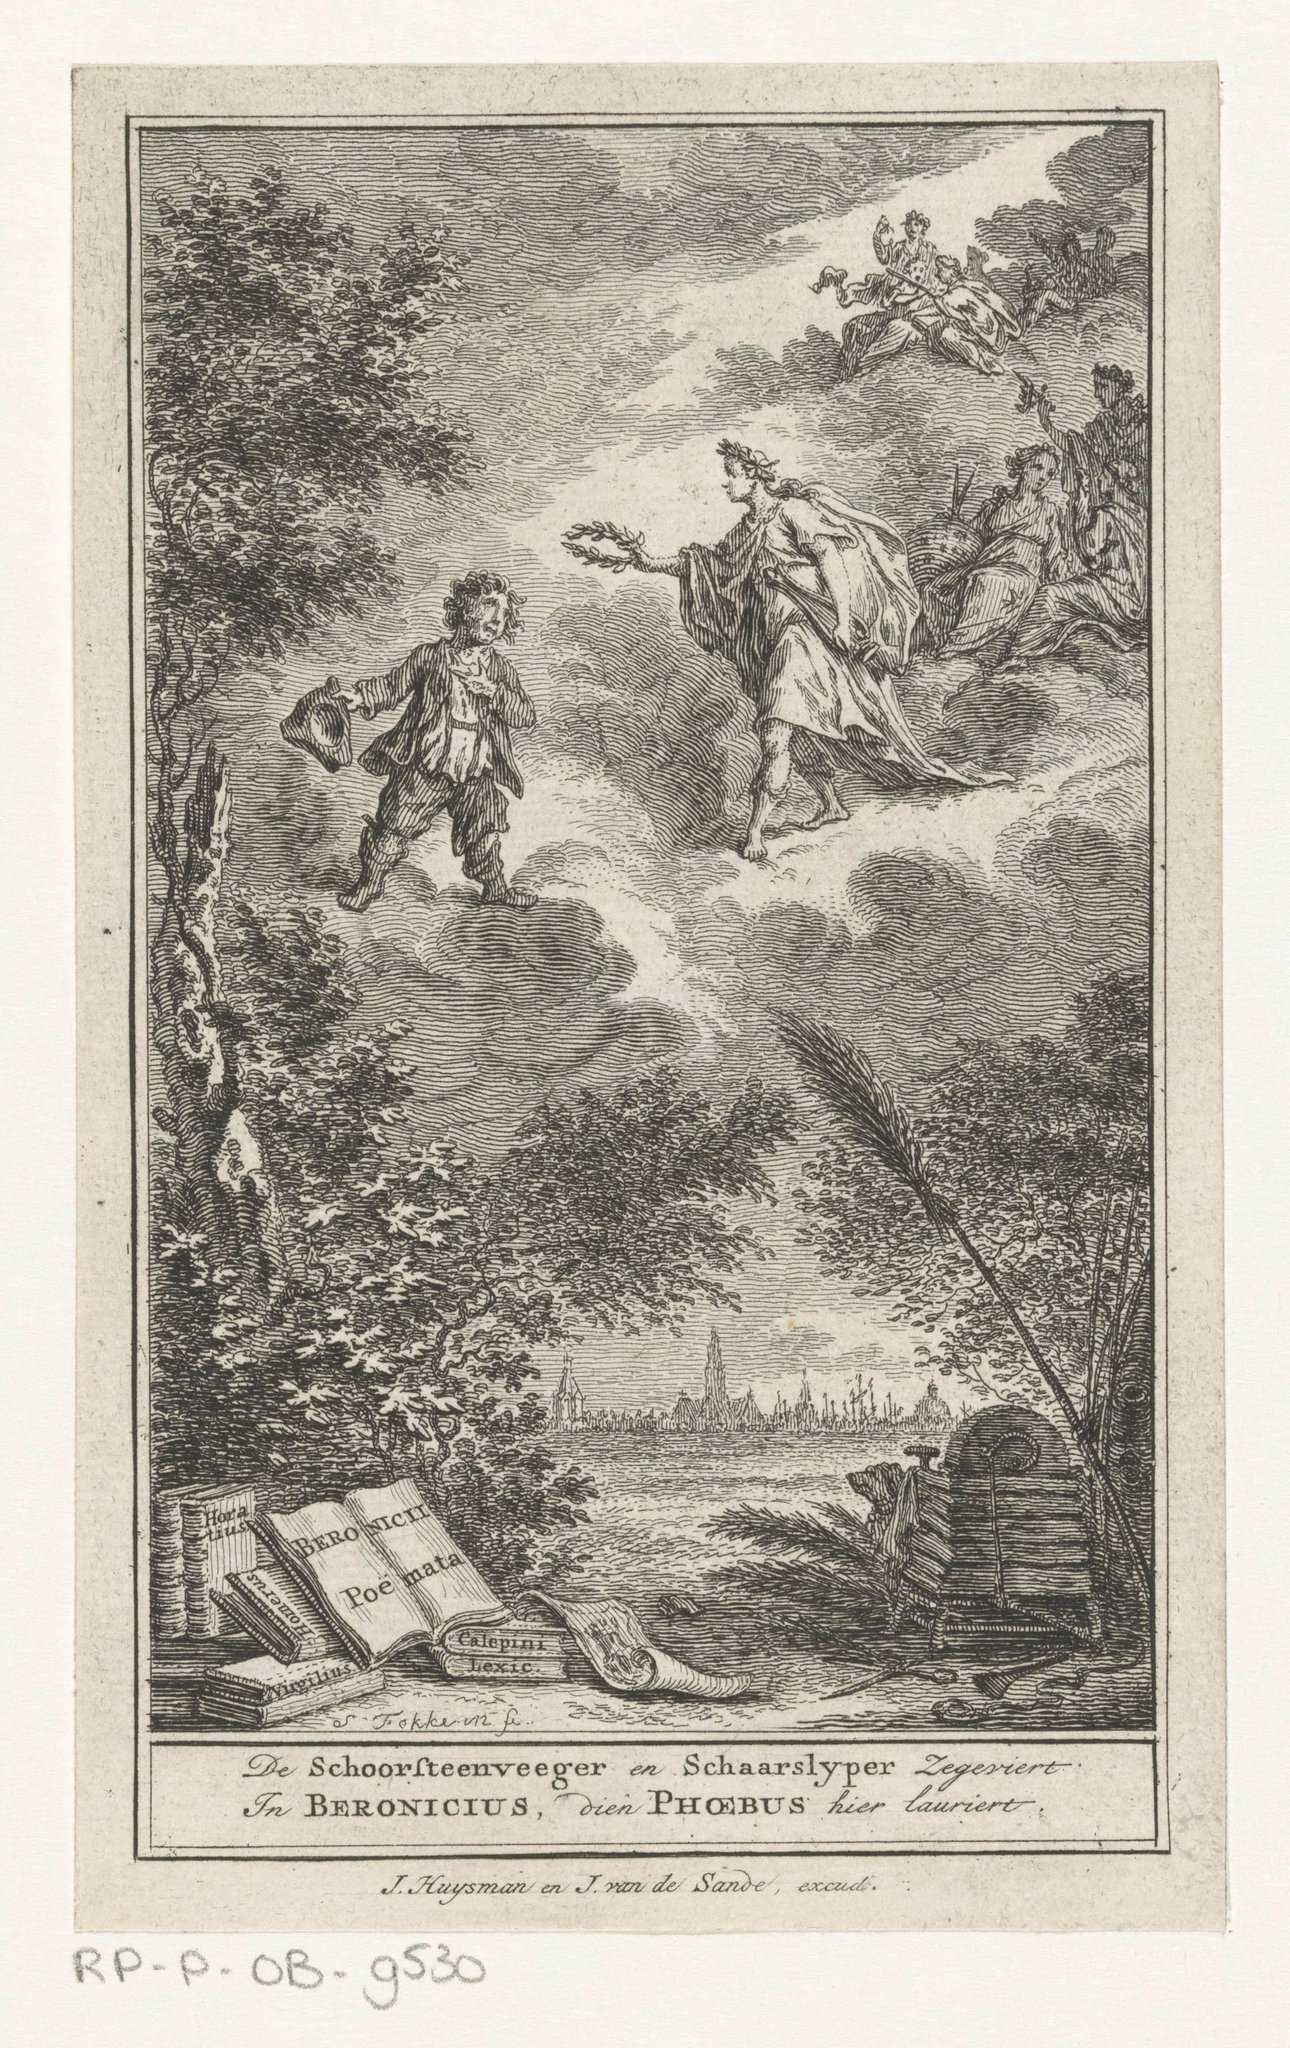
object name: titelblad, titelpagina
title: Titelpagina voor: Petrus Johannes Beronicius, P.J. Beronicii Georgarchontomachia (...), 1766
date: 1766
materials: paper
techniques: etching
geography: middelburg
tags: specific aspects, allegorical aspects of apollo; apollo as patron - veneration, honoured by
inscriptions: collector's mark: Lugt 2228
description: Titelpagina voor: Beronicius, Petrus Johannes. P.J. Beronicii Georgarchontomachia. Goes: Huysman, Jacobus, Middelurg: Sande, Jeroen van de, 1766. Titelpagina voor een gedicht van Beronicius over de opstandige Zeeuwse boeren en het tumult te Middelburg rond burgemeester Filips van den Brande op 21 juli 1672.